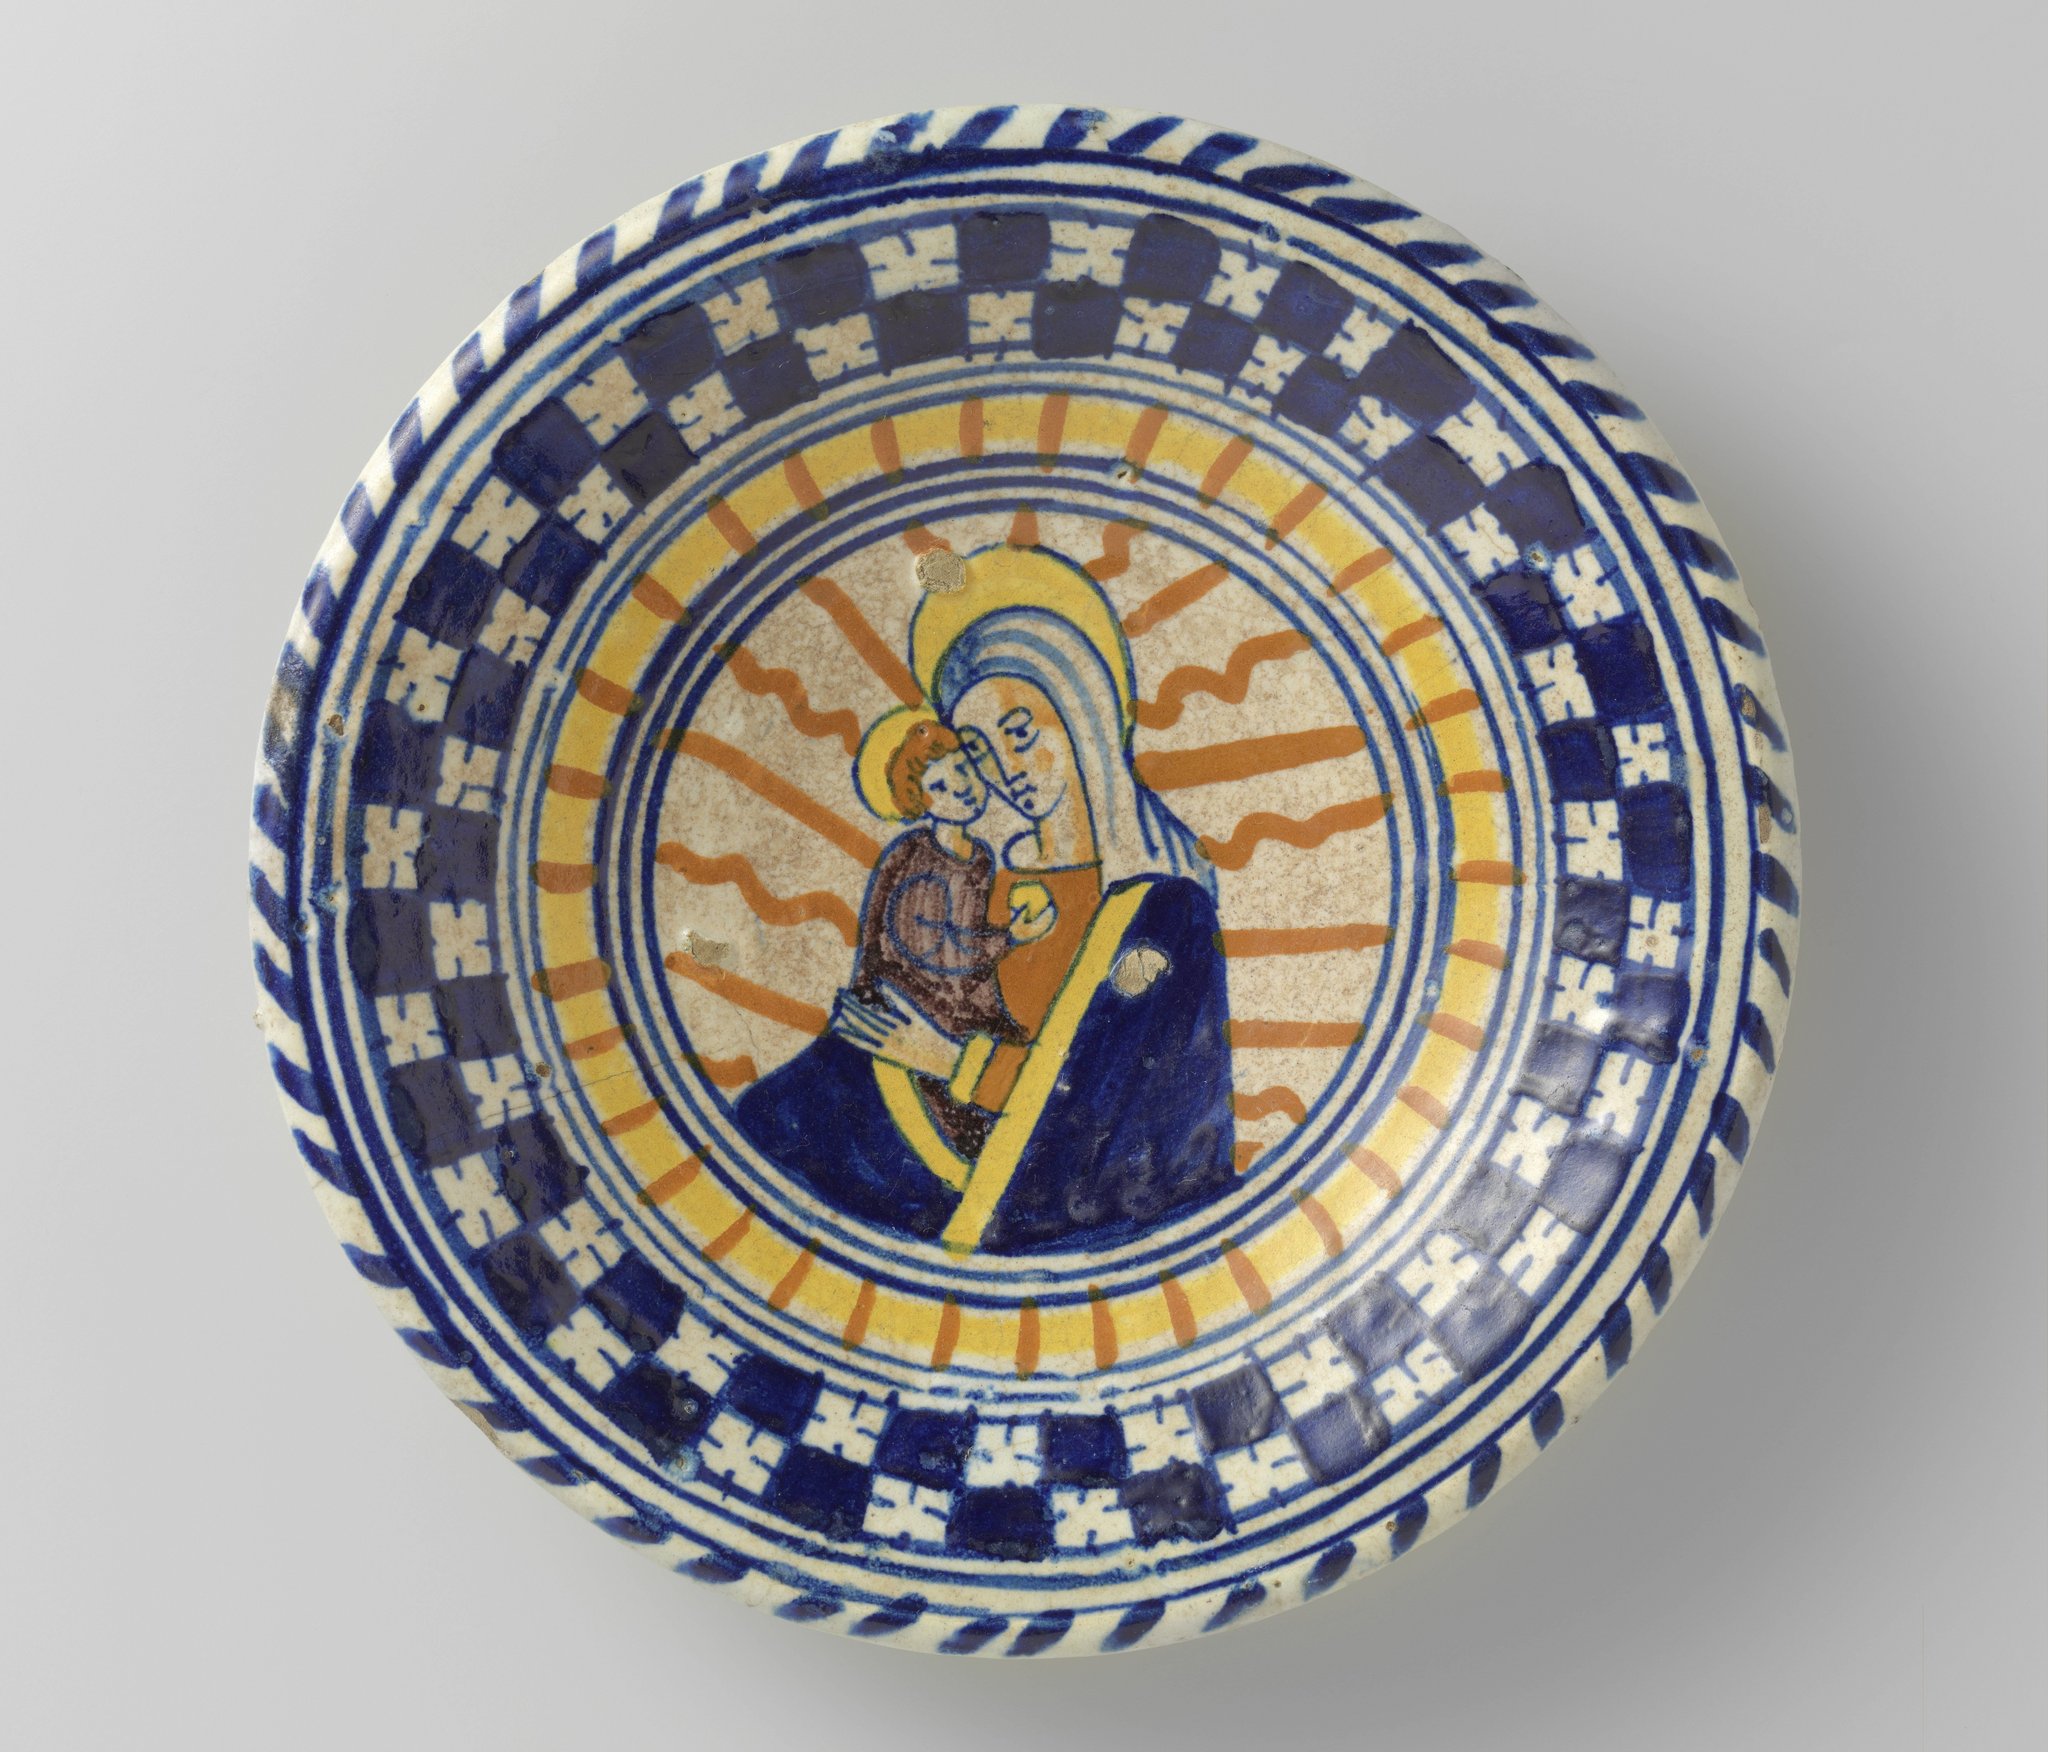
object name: platter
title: Dish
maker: Anonymous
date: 1590-1620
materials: earthenware, glaze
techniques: maiolica, painted, polychromy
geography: netherlands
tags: madonna: i.e. mary with the christ-child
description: Ronde schotel van veelkleurig beschilderde majolica. Op het plat is binnen drie blauwe cirkels een Madonna met Kind geschilderd, omgeven door oranje stralen. Op de rand is in blauw-wit een ruitmotief geschilderd (schaakbordmotief).